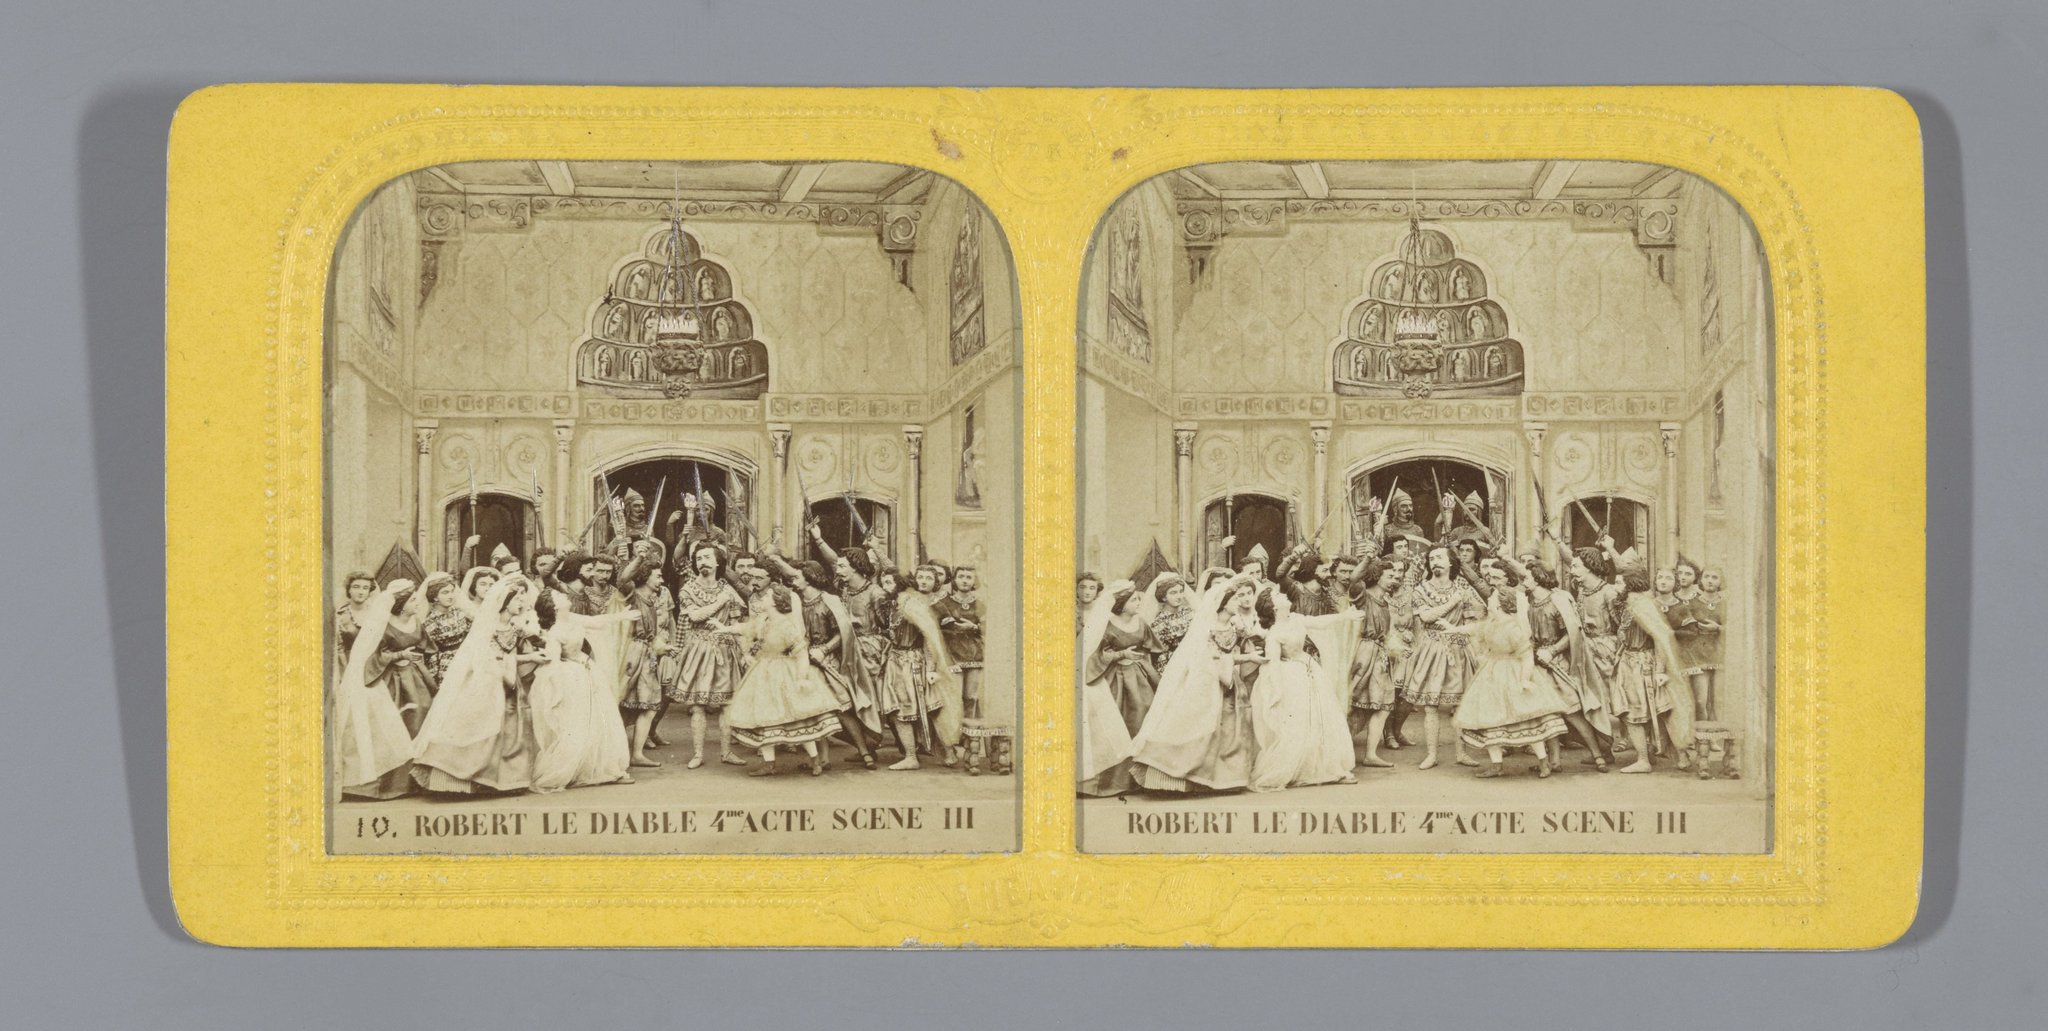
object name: tissue stereograph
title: Les theatres Paris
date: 1873-1874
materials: cardboard, paper, photographic support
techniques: albumen print, cutting, hand coloring, perforating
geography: paris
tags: opera, paris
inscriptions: inscription: ‘DÉPOSÉ/ Ch D’, number: ‘10.’, inscription: ‘Toutes les épreuves non revêtues du timbre ci-contre/ seront considérées comme contrefacon, le Dépôt/ ayant été fait en France selon la loi et à l' Etranger/ conformément aux conventions internationales./ PROPRIÉTÉ/ B.K./ PARIS’